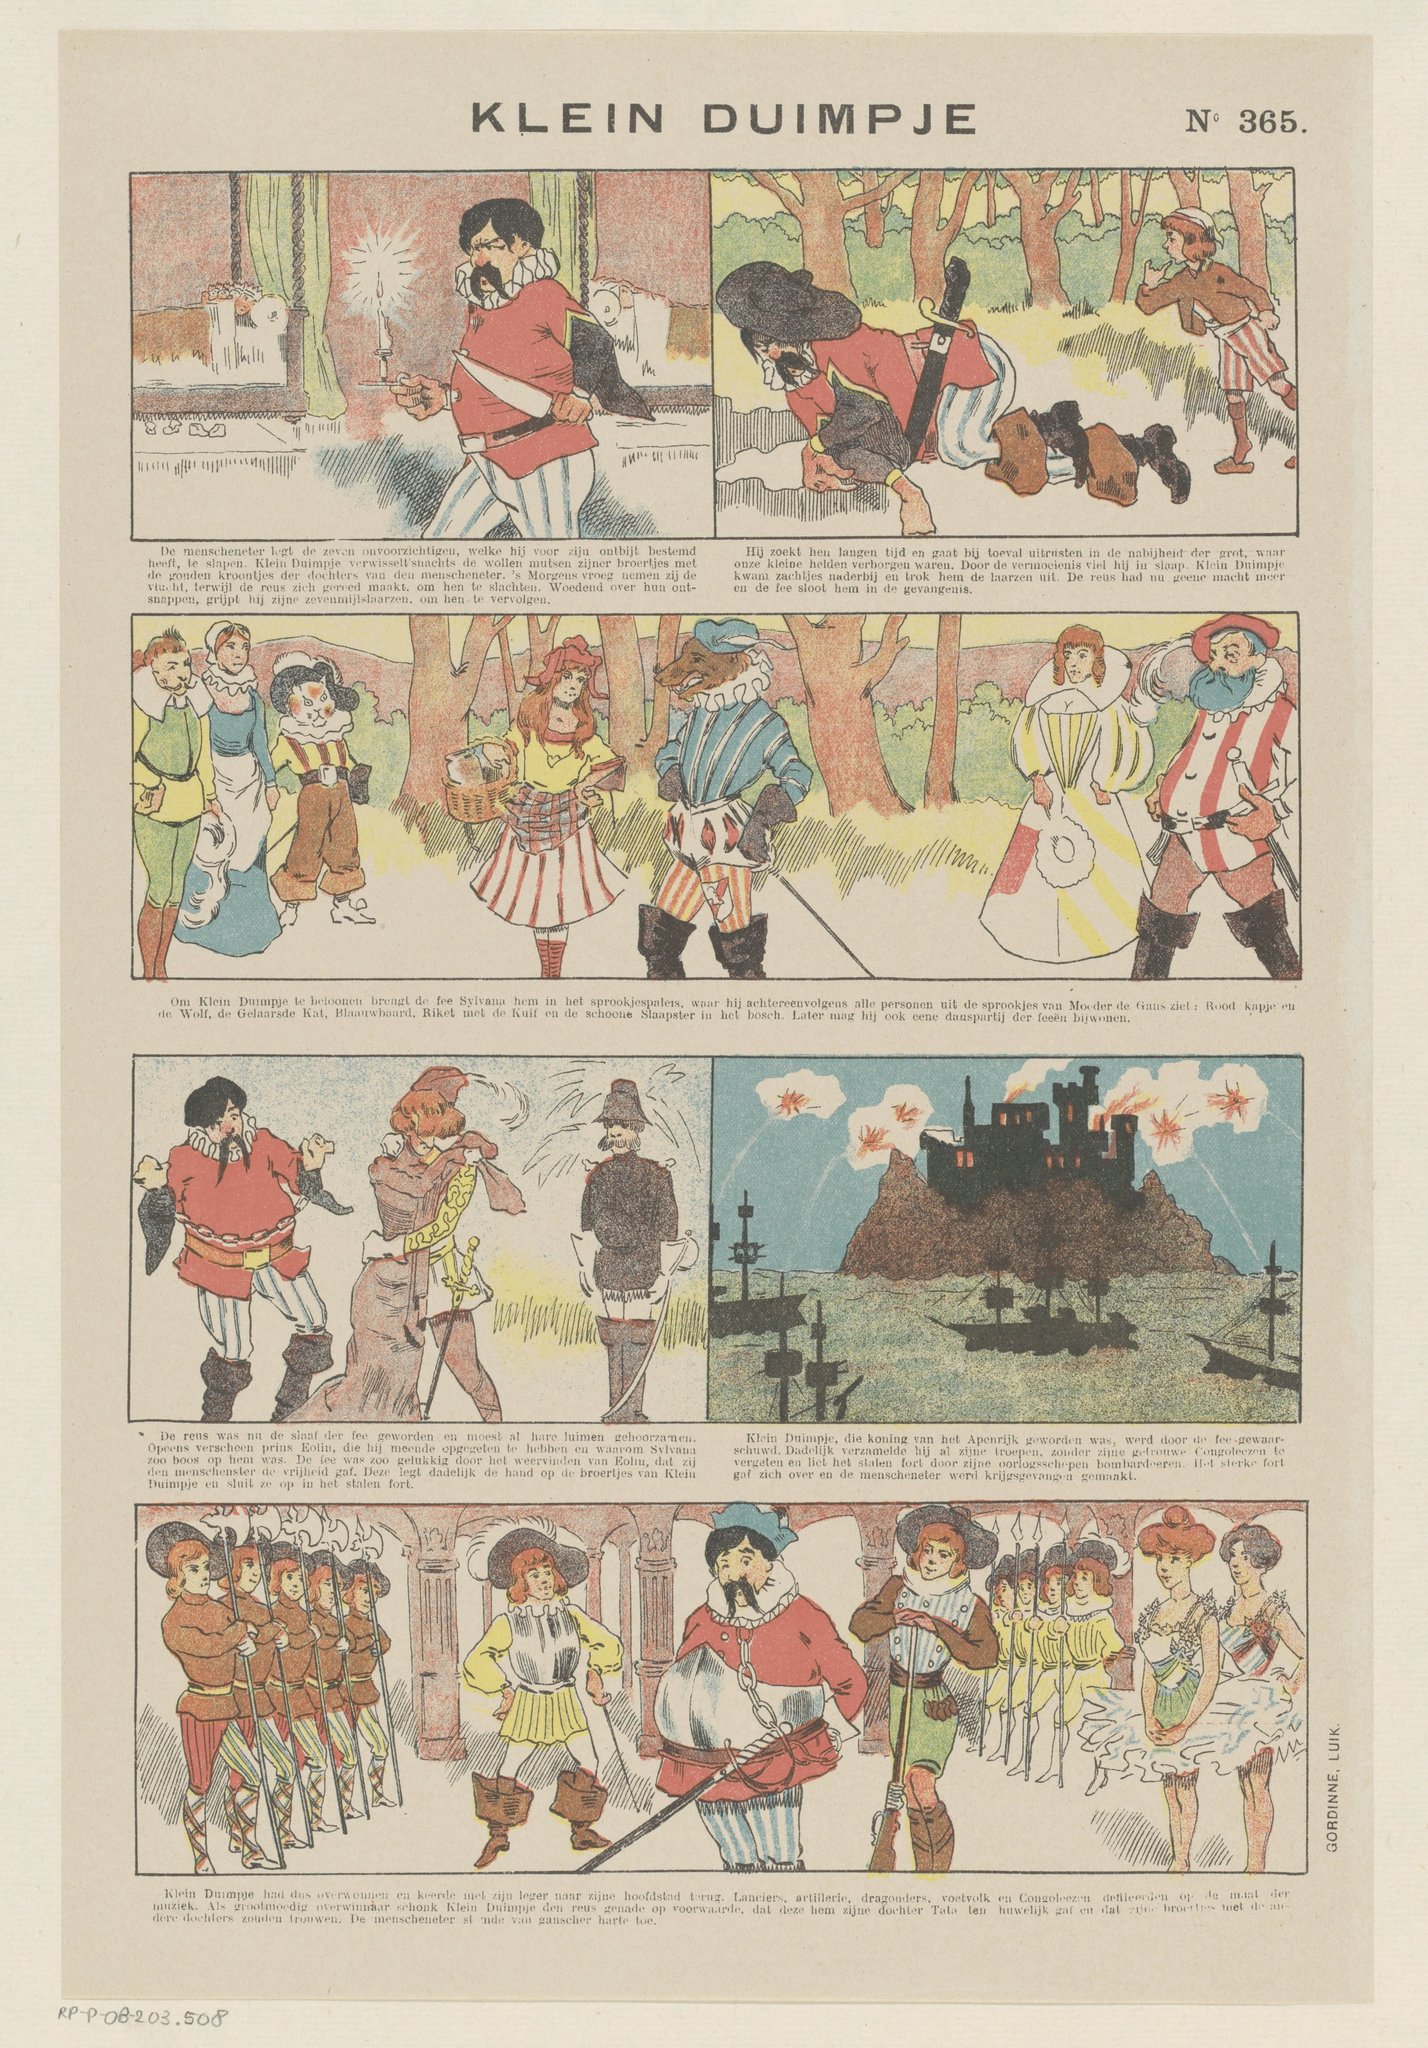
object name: print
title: Klein Duimpje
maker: Anonymous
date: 1894-1959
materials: paper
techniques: lithograph, letterpress printing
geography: liège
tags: tales and fairy tales: little thumbling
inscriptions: collector's mark: Lugt 2760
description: Blad met 6 voorstellingen uit het sprookje van Klein Duimpje. Onder elke afbeelding een onderschrift. Genummerd rechtsboven: No 365.